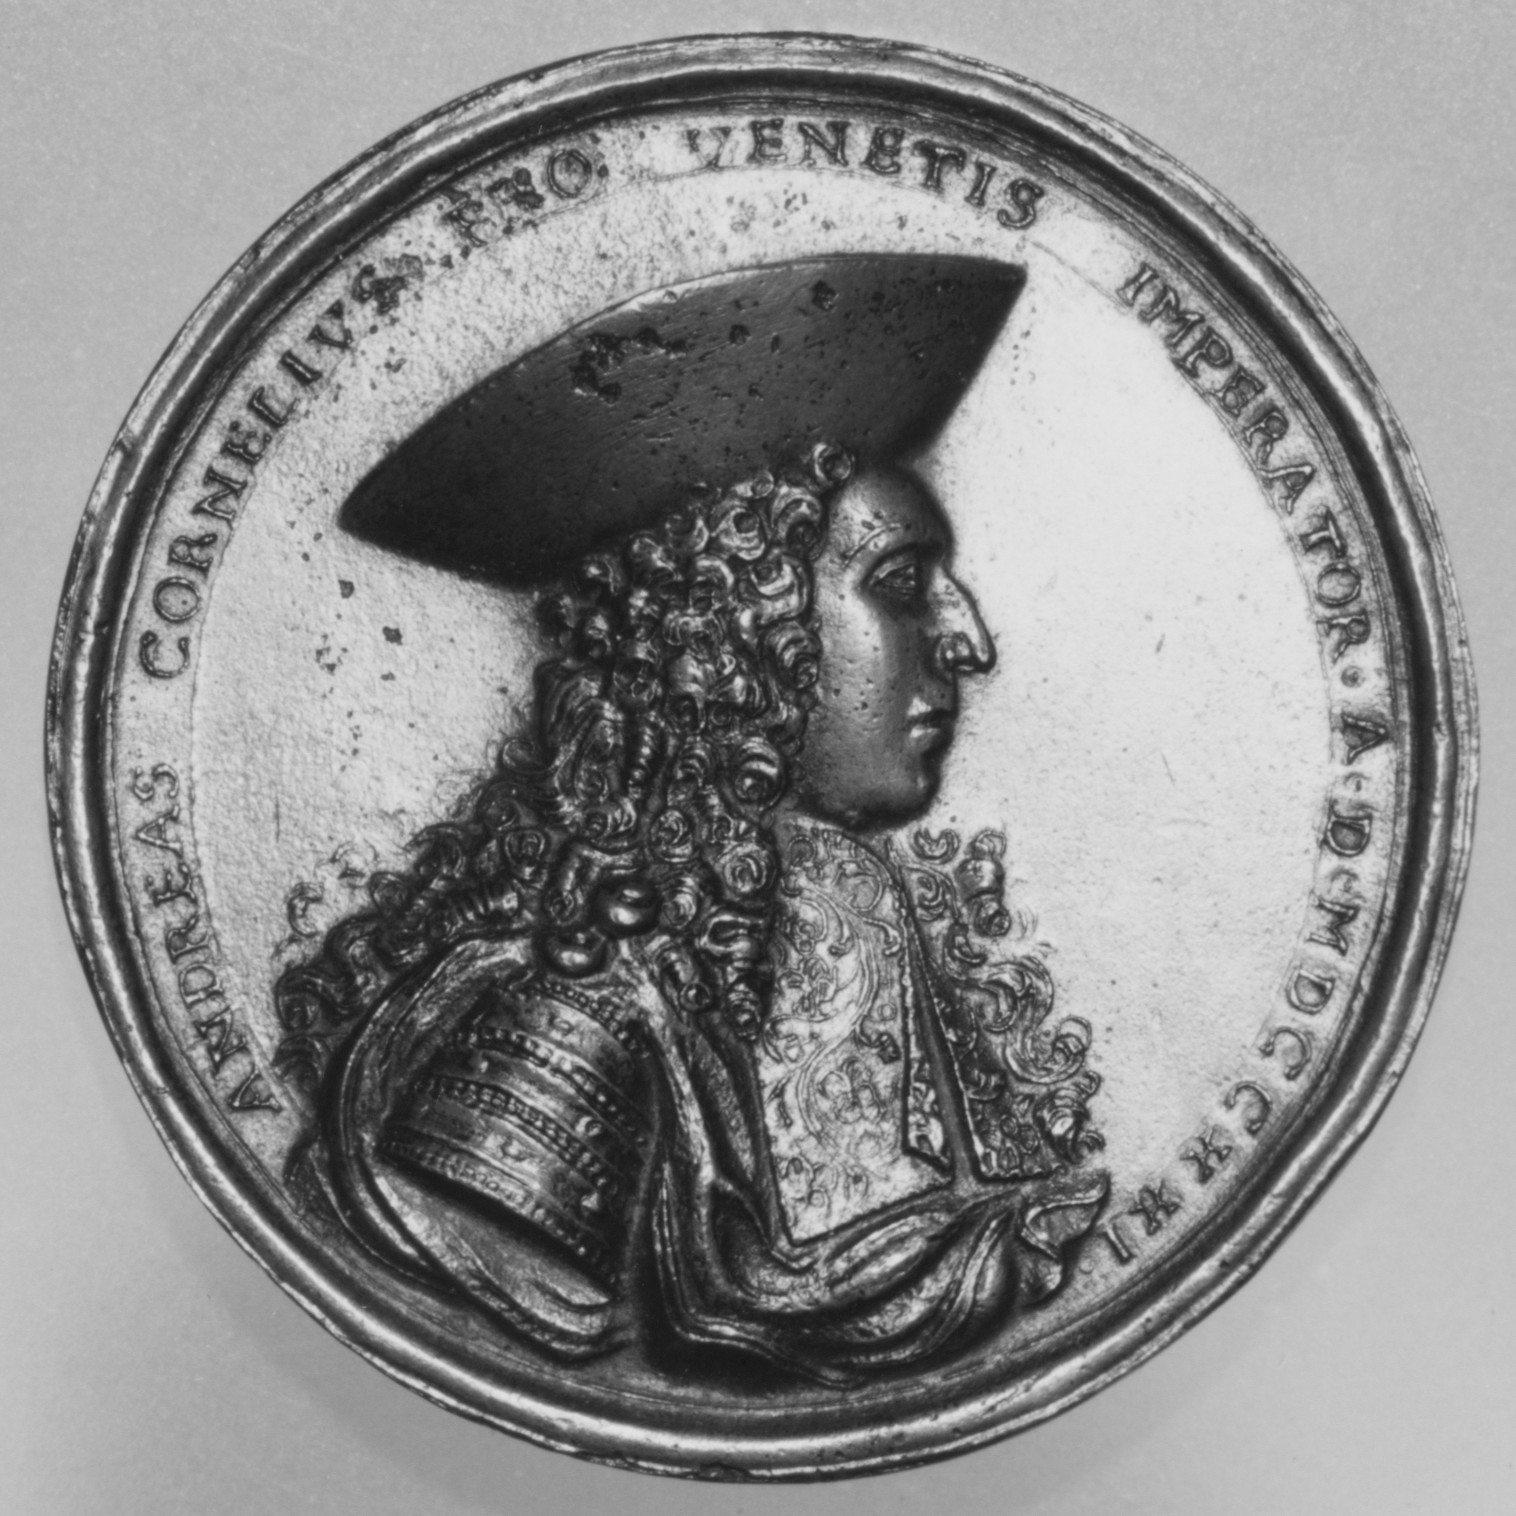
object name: medal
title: Andrea Cornaro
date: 1721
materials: bronze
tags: men,profiles